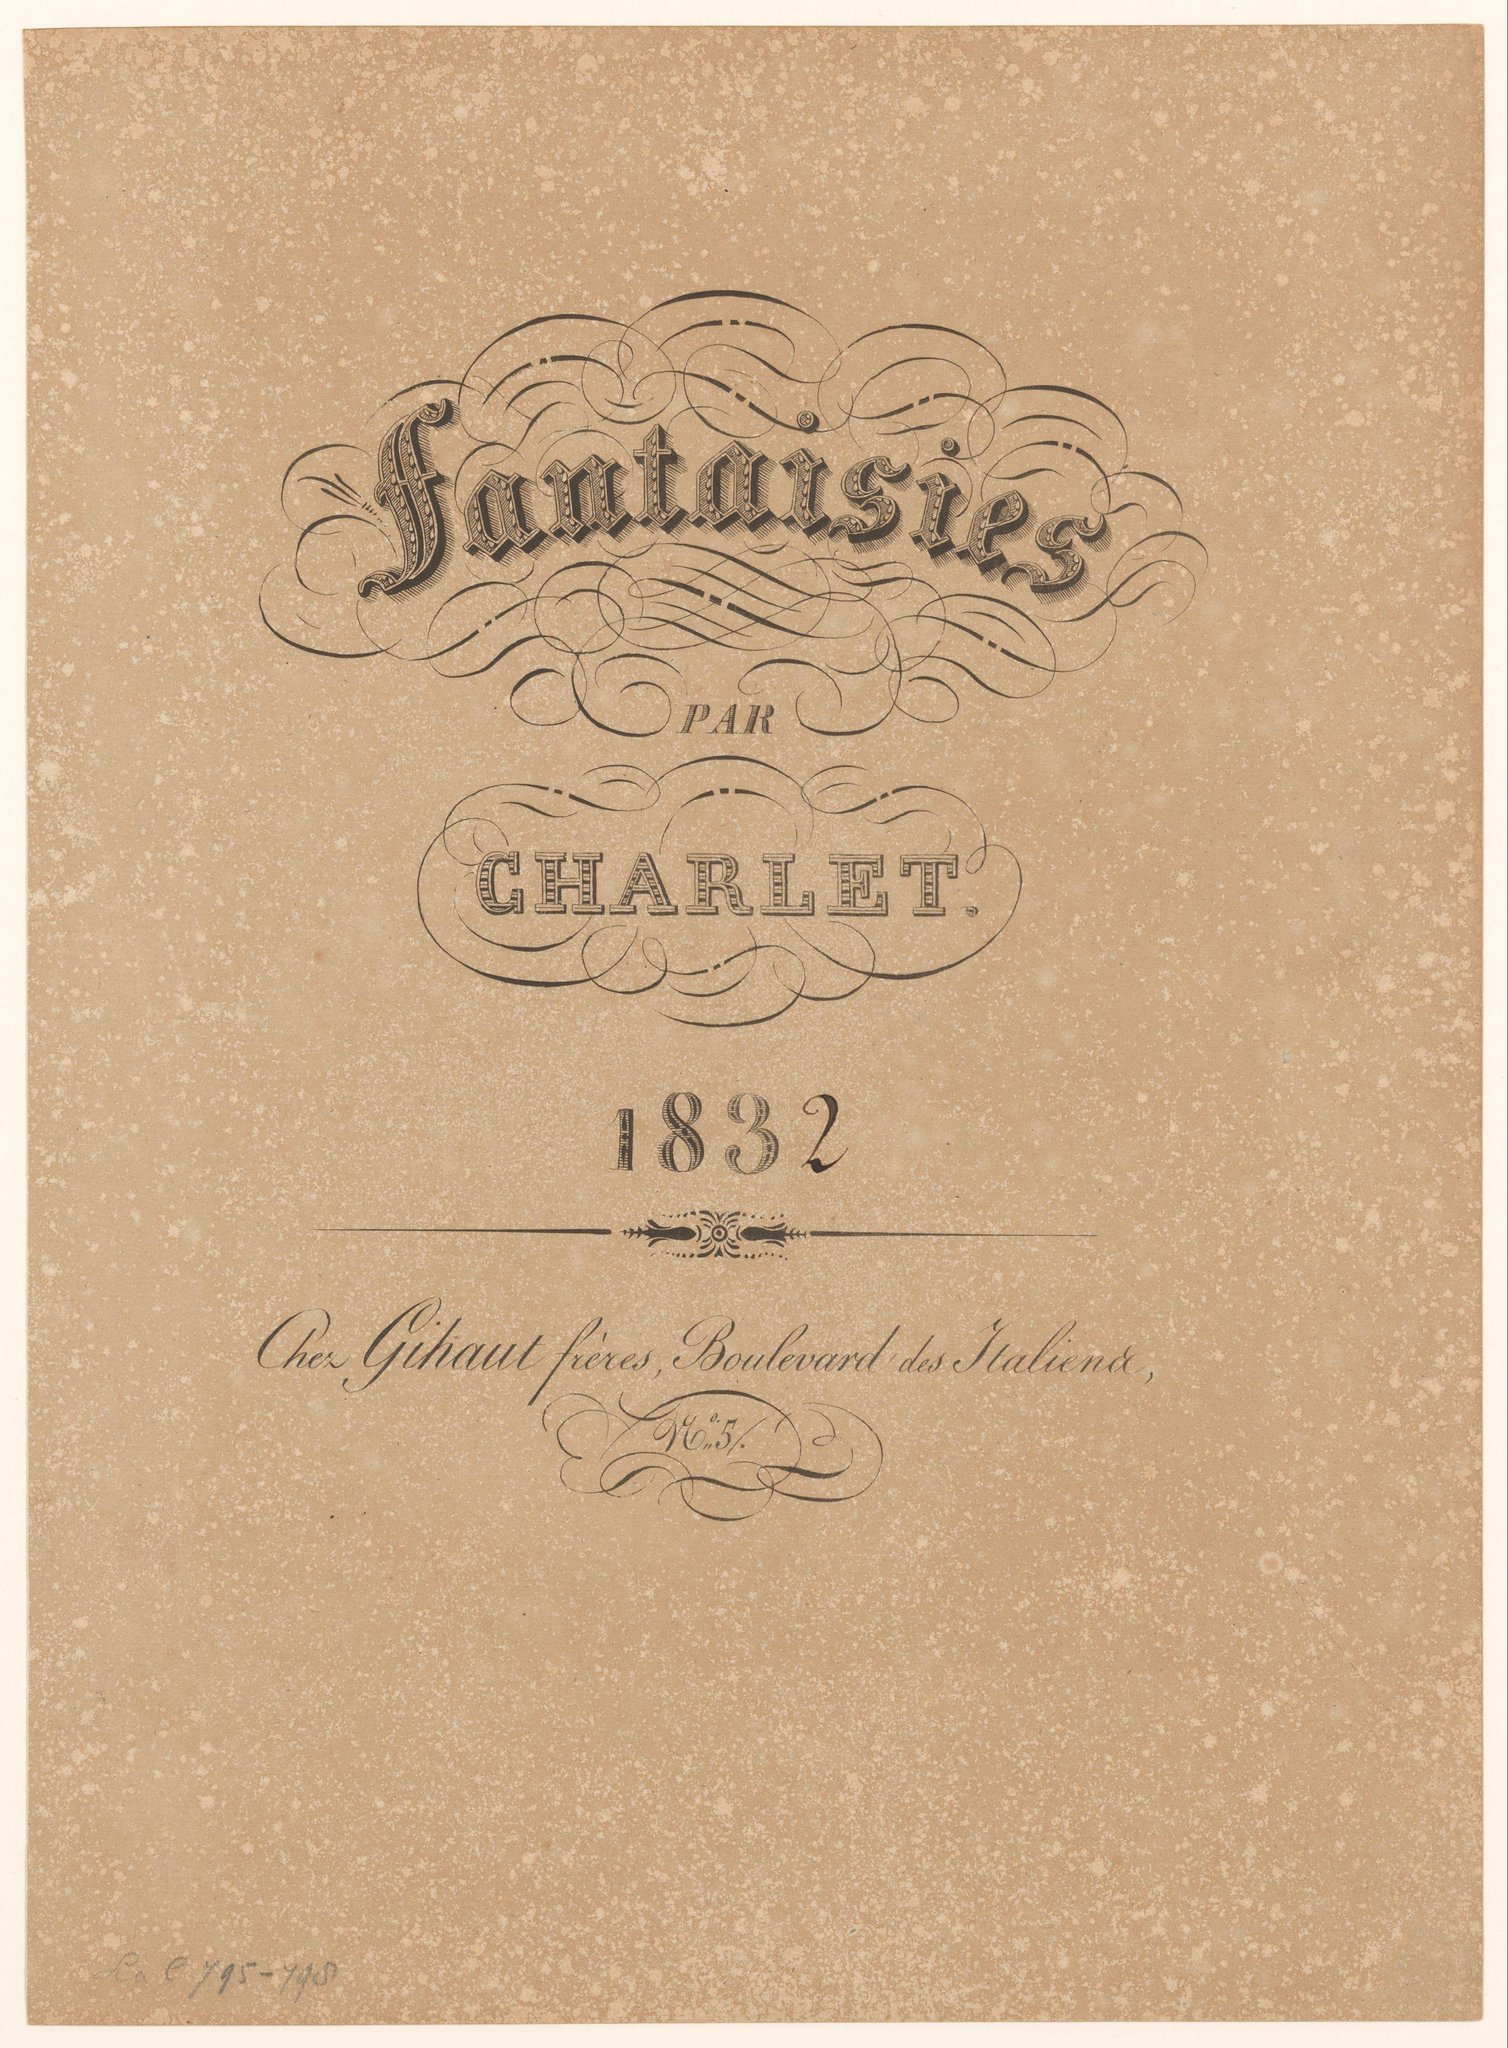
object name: wrapper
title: Omslag voor: Fantasieën 1832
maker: nicolas toussaint charlet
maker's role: draughtsman, painter, print maker, printer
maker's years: 1792-1845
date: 1832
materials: paper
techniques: pen lithography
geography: paris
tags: calligraphy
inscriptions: date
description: Omslag met vier prenten, genummerd 1 tot en met 4.